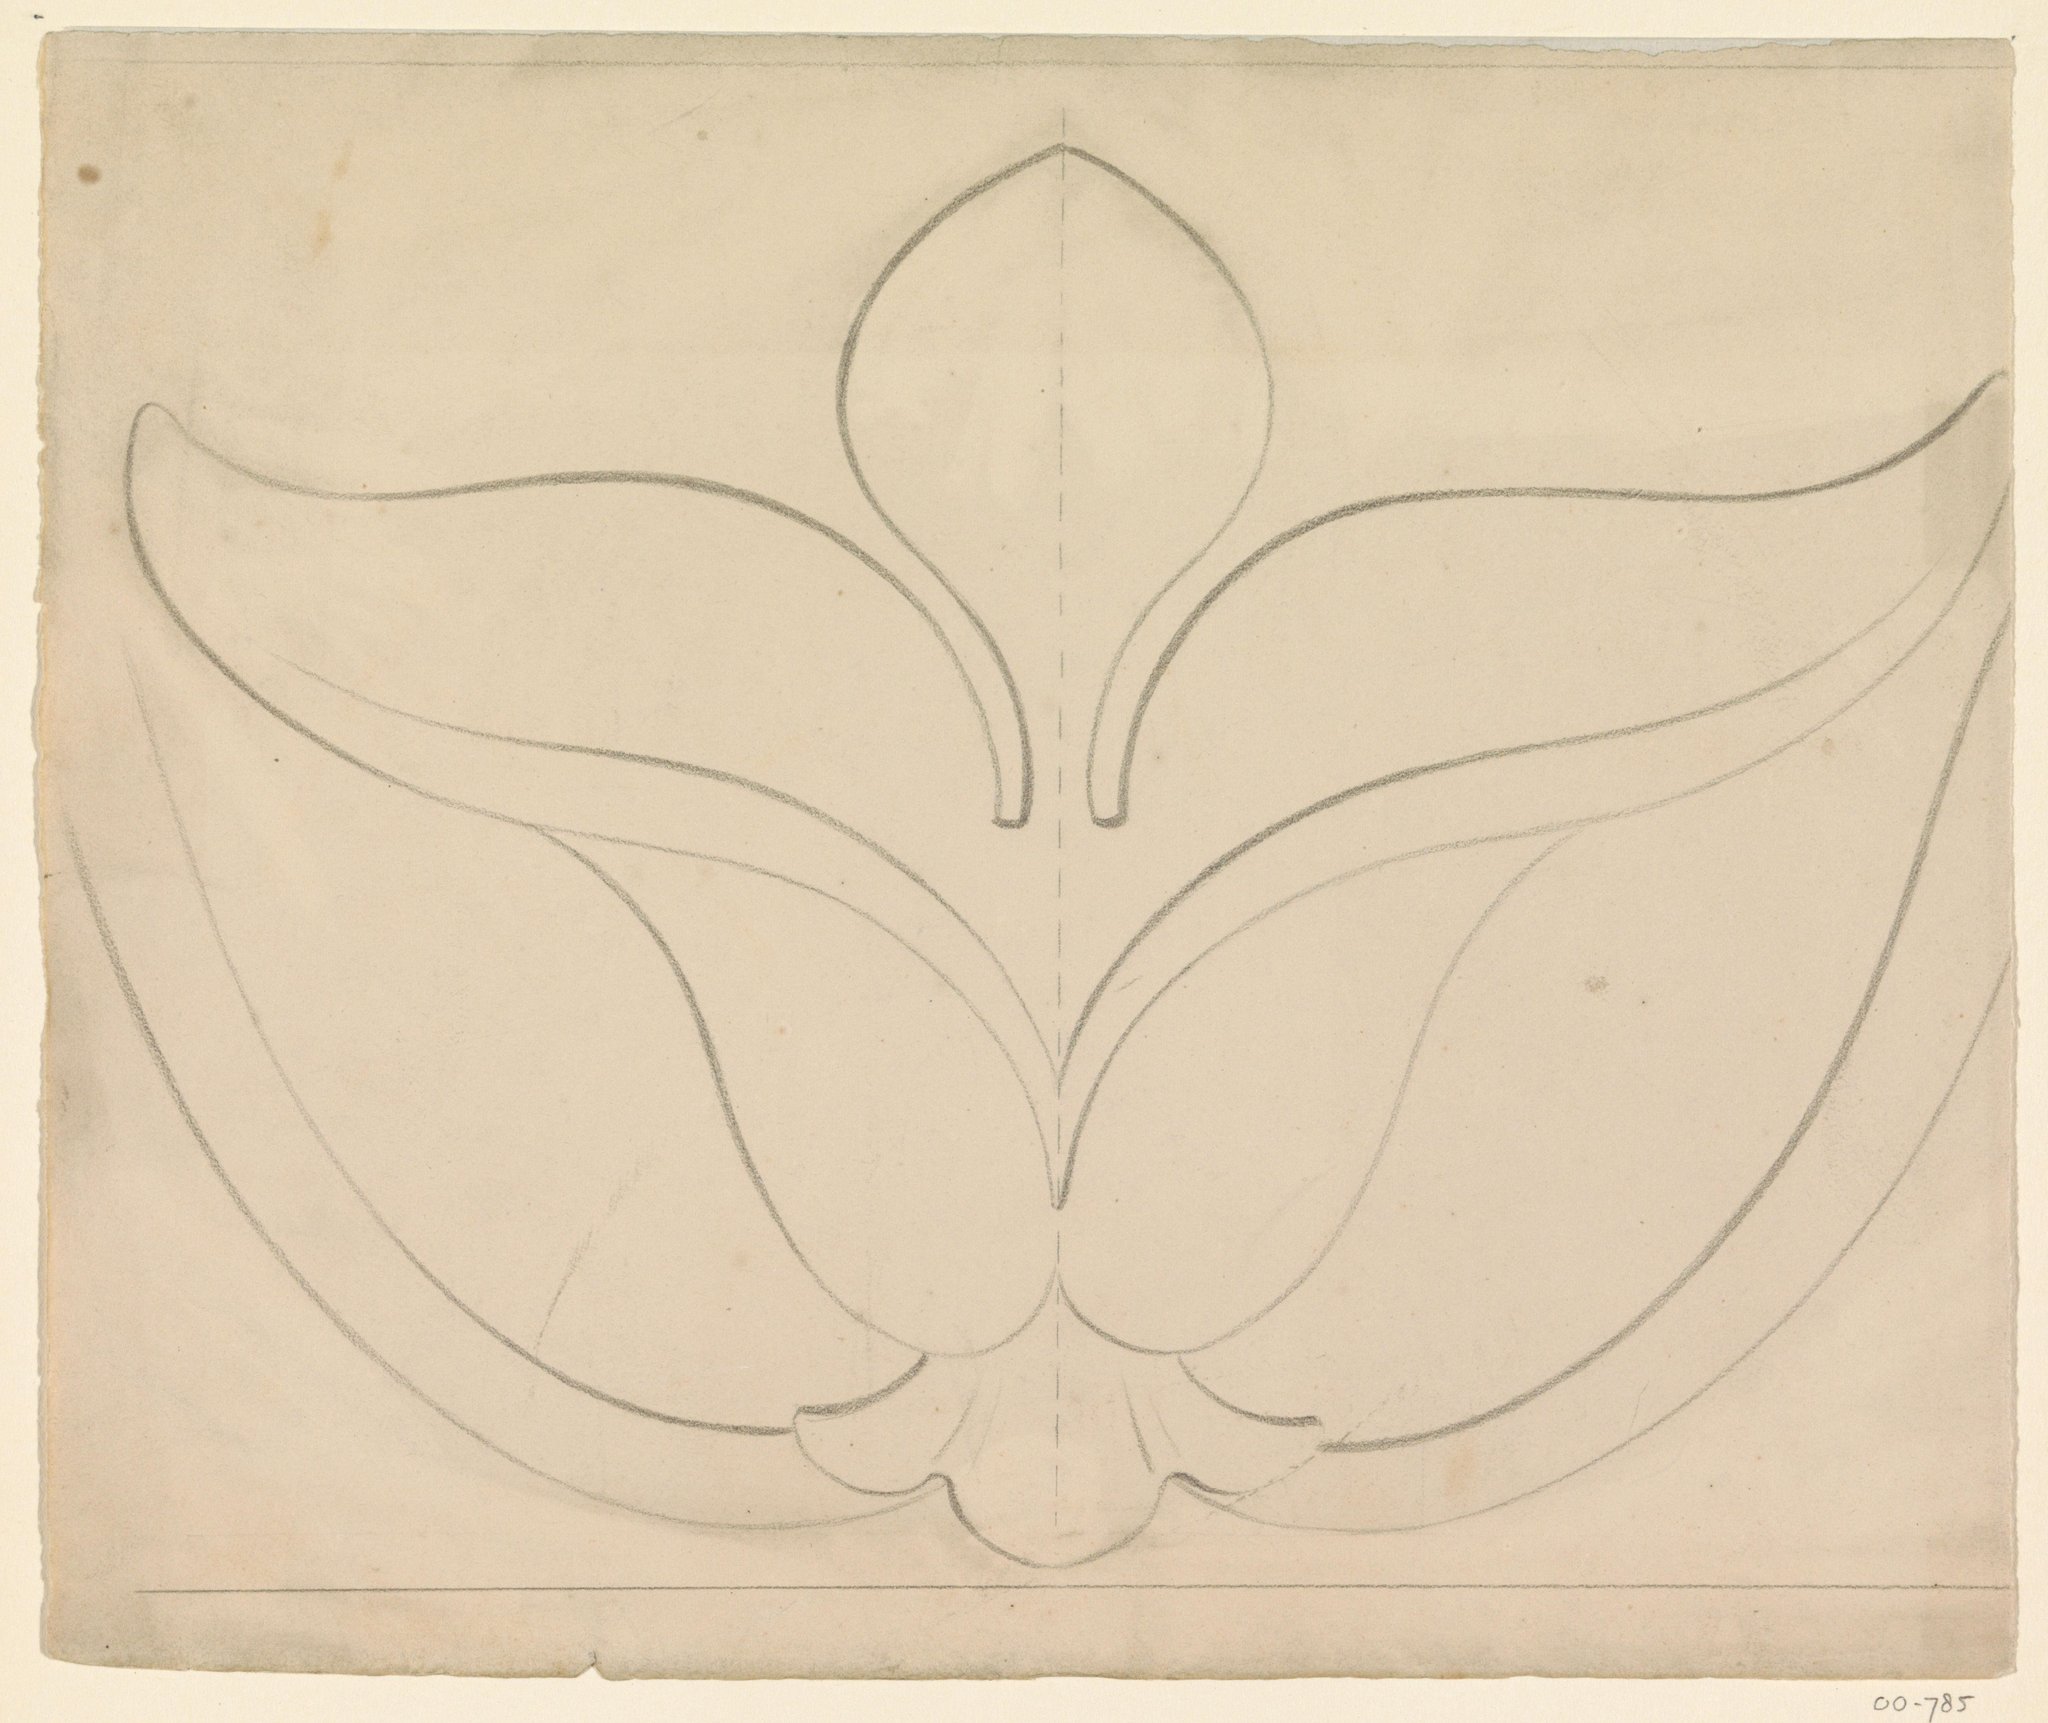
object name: ornamenttekening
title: Floraal ornament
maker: Anonymous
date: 1700-1900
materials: paper, pencil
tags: flowers ~ ornament - aa - stylized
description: Ontwerp voor een gestileerd floraal ornament